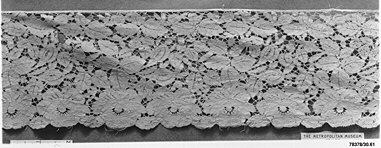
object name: strip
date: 1801-1850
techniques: lace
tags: flowers